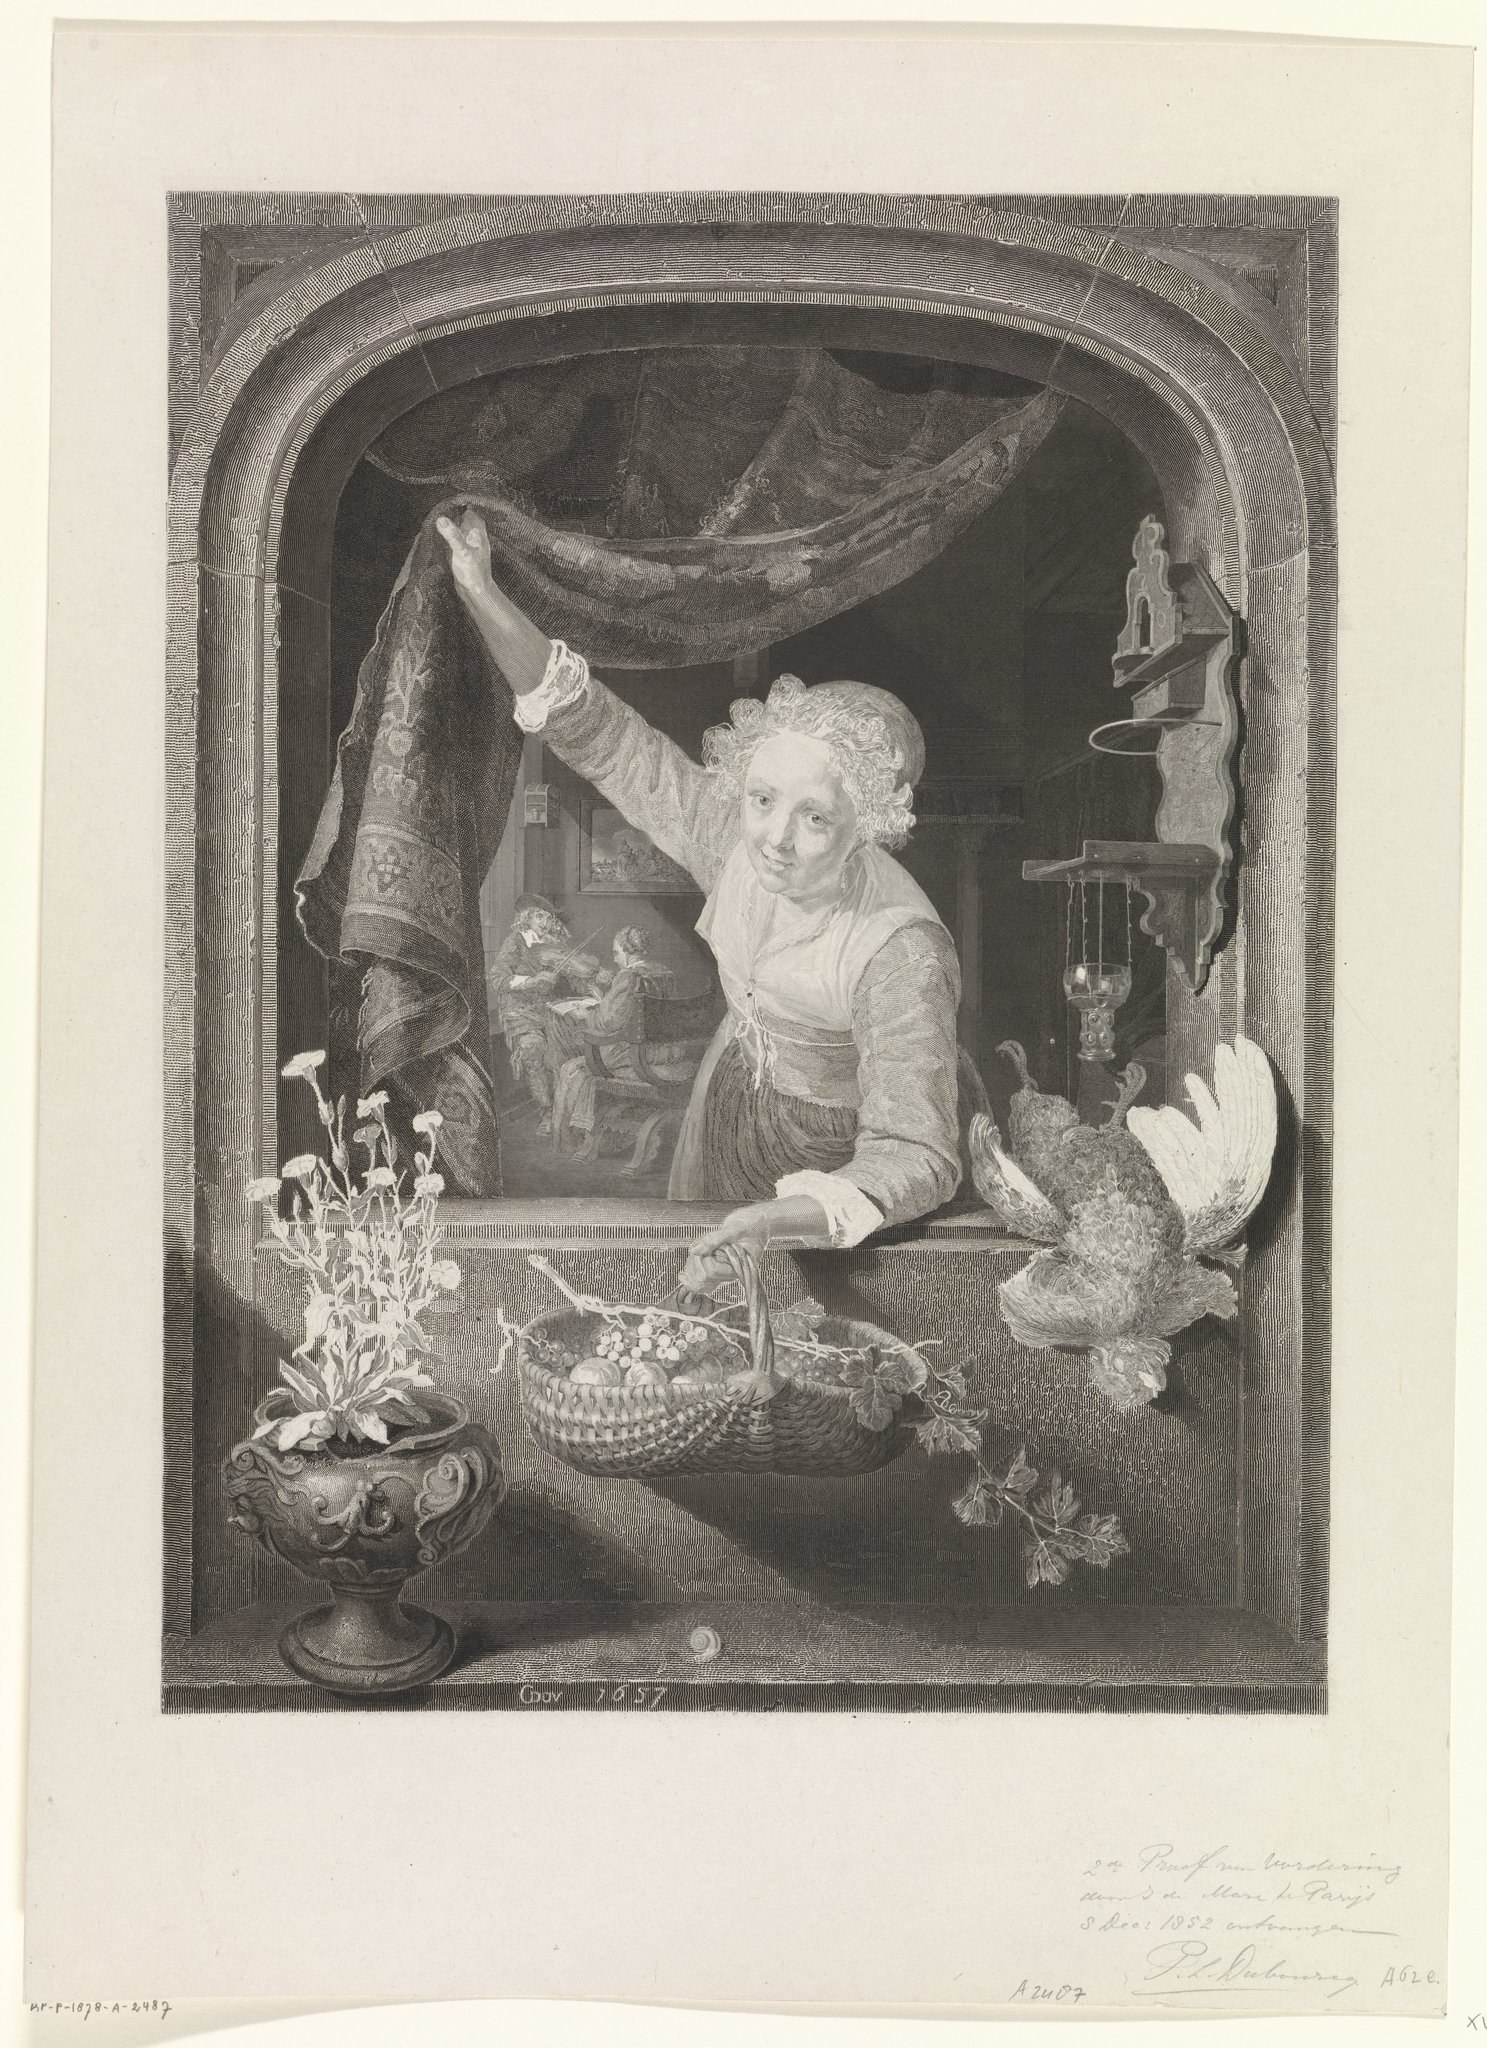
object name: print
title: Vrouw met mand met vruchten in de hand bij het raam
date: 1852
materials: paper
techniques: engraving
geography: paris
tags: nesting-box, instrumental and vocal music together, human figure at (open) window, seen from outside, attributes of aesculapius: cock, maid ~ house personnel, shop-window, show-window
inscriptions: inscription: ‘2de Proef van vordering / door De Mare te Parijs / 8 Dec 1852 ontvangen / Ph [...]’, collector's mark: Lugt 2228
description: Een jonge vrouw met een mand met vruchten in de hand hangt uit een venster. Ze houdt het gordijn opzij zodat het interieur achter haar zichtbaar is. In het vertrek zijn een man en een vrouw aan het musiceren. In de vensterbank hangt een vogelhuis, ligt een dode haan en staat een vaas met bloemen.